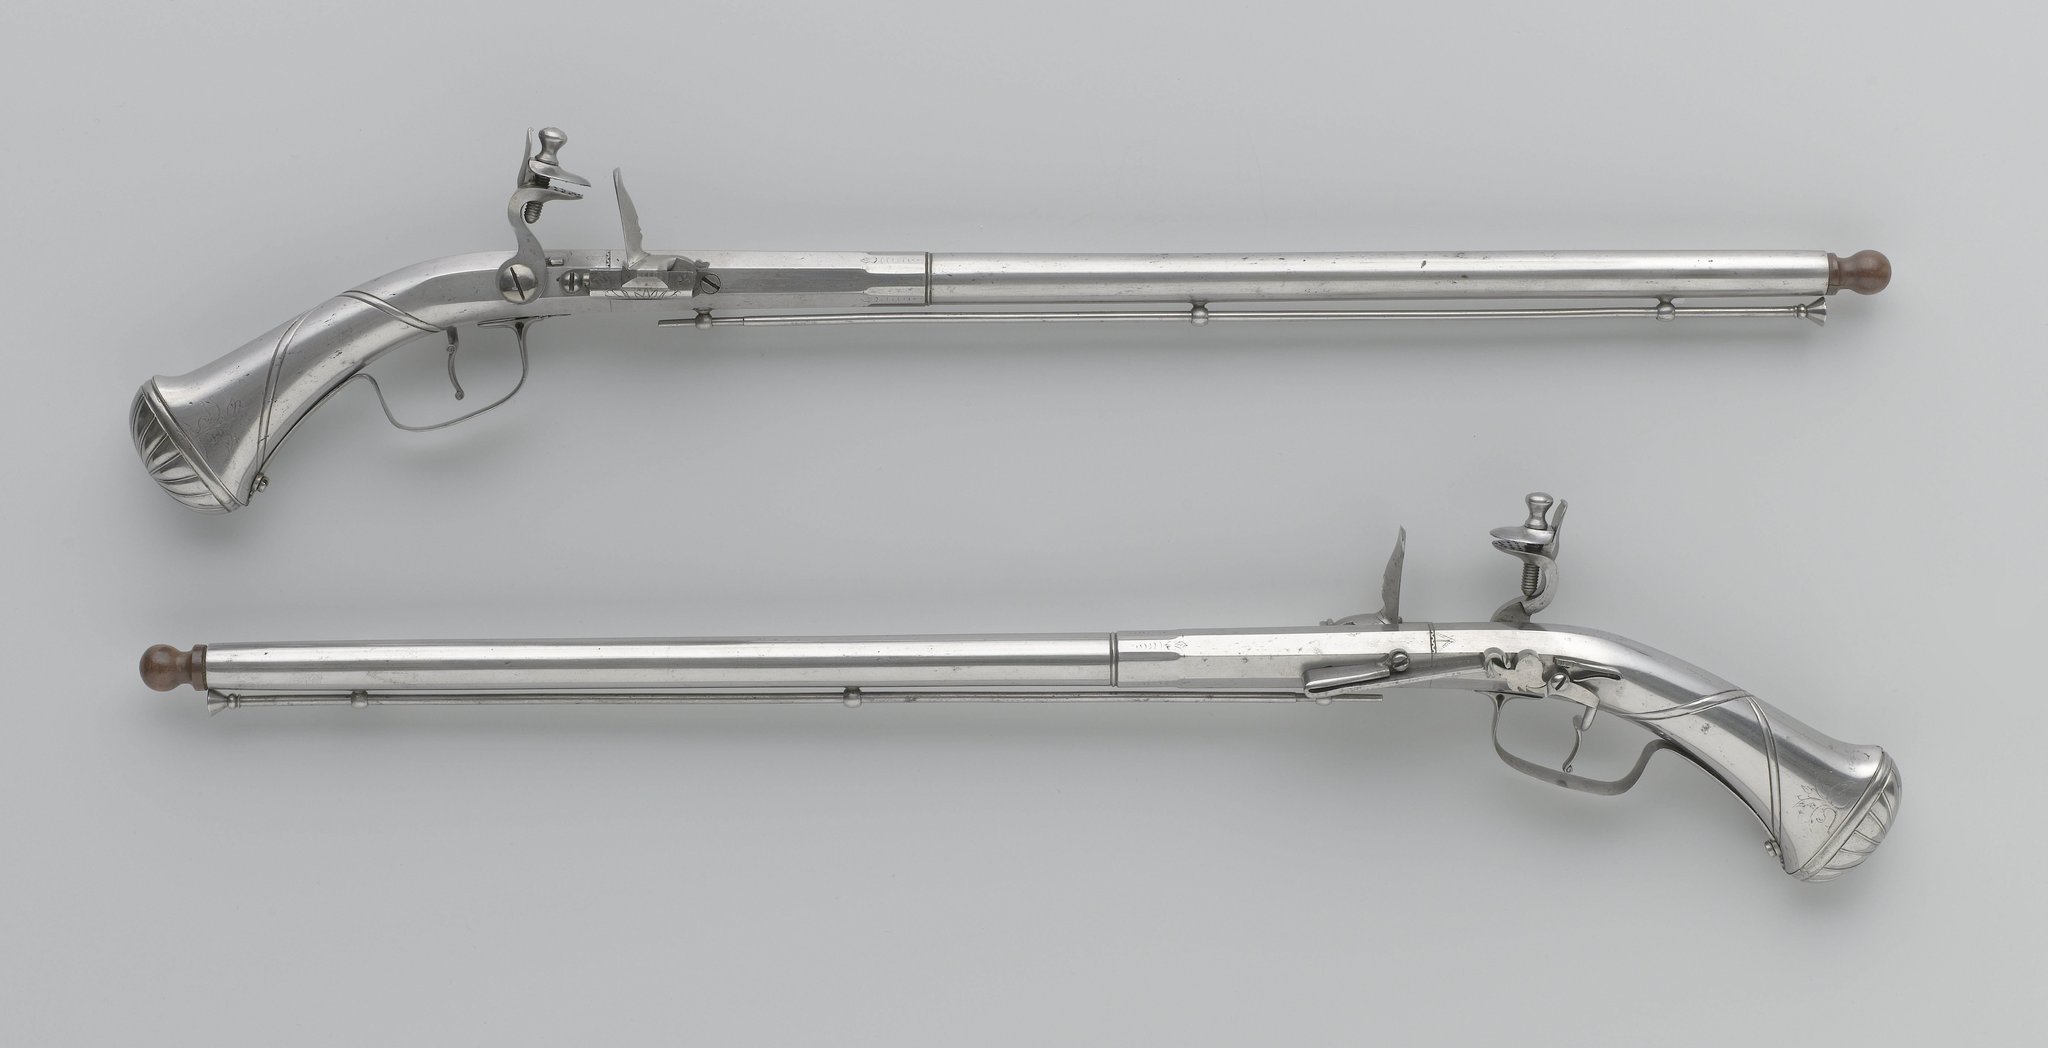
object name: flintlock pistol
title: Vuursteenpistool met ijzeren kolf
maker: Anonymous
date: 1645-1650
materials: iron, steel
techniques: engraving, soldering